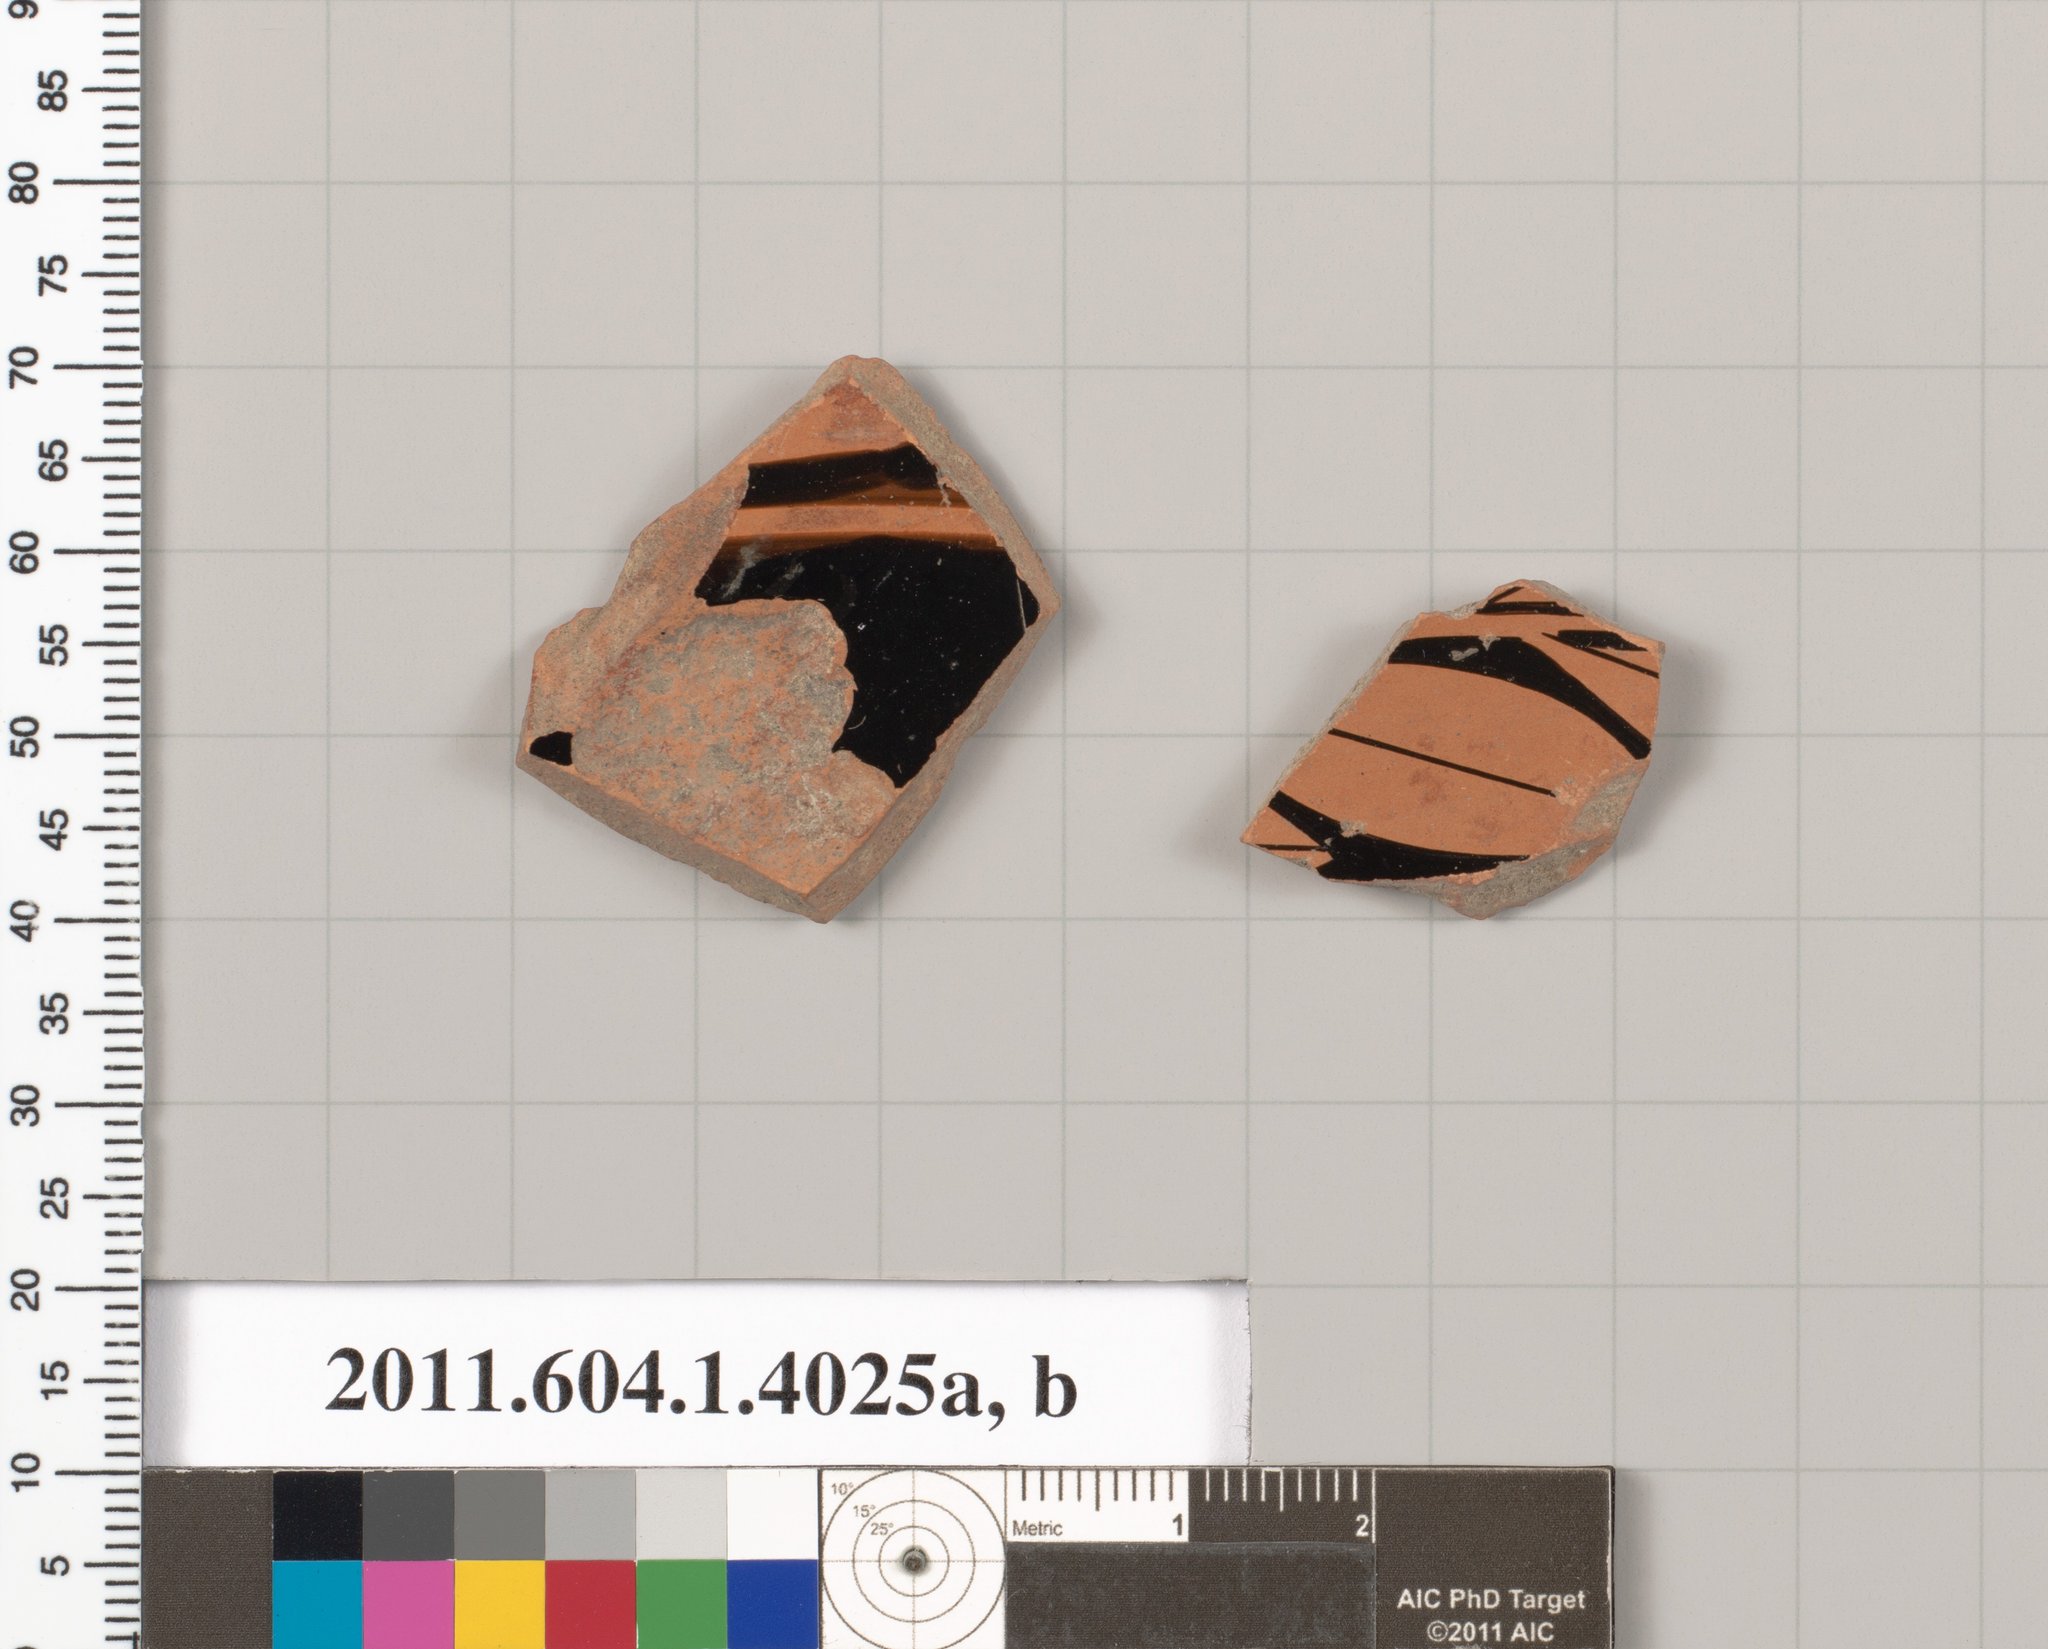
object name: kylix fragment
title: Terracotta fragments of kylikes (drinking cups)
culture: greek, attic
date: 460-440 BCE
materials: terracotta